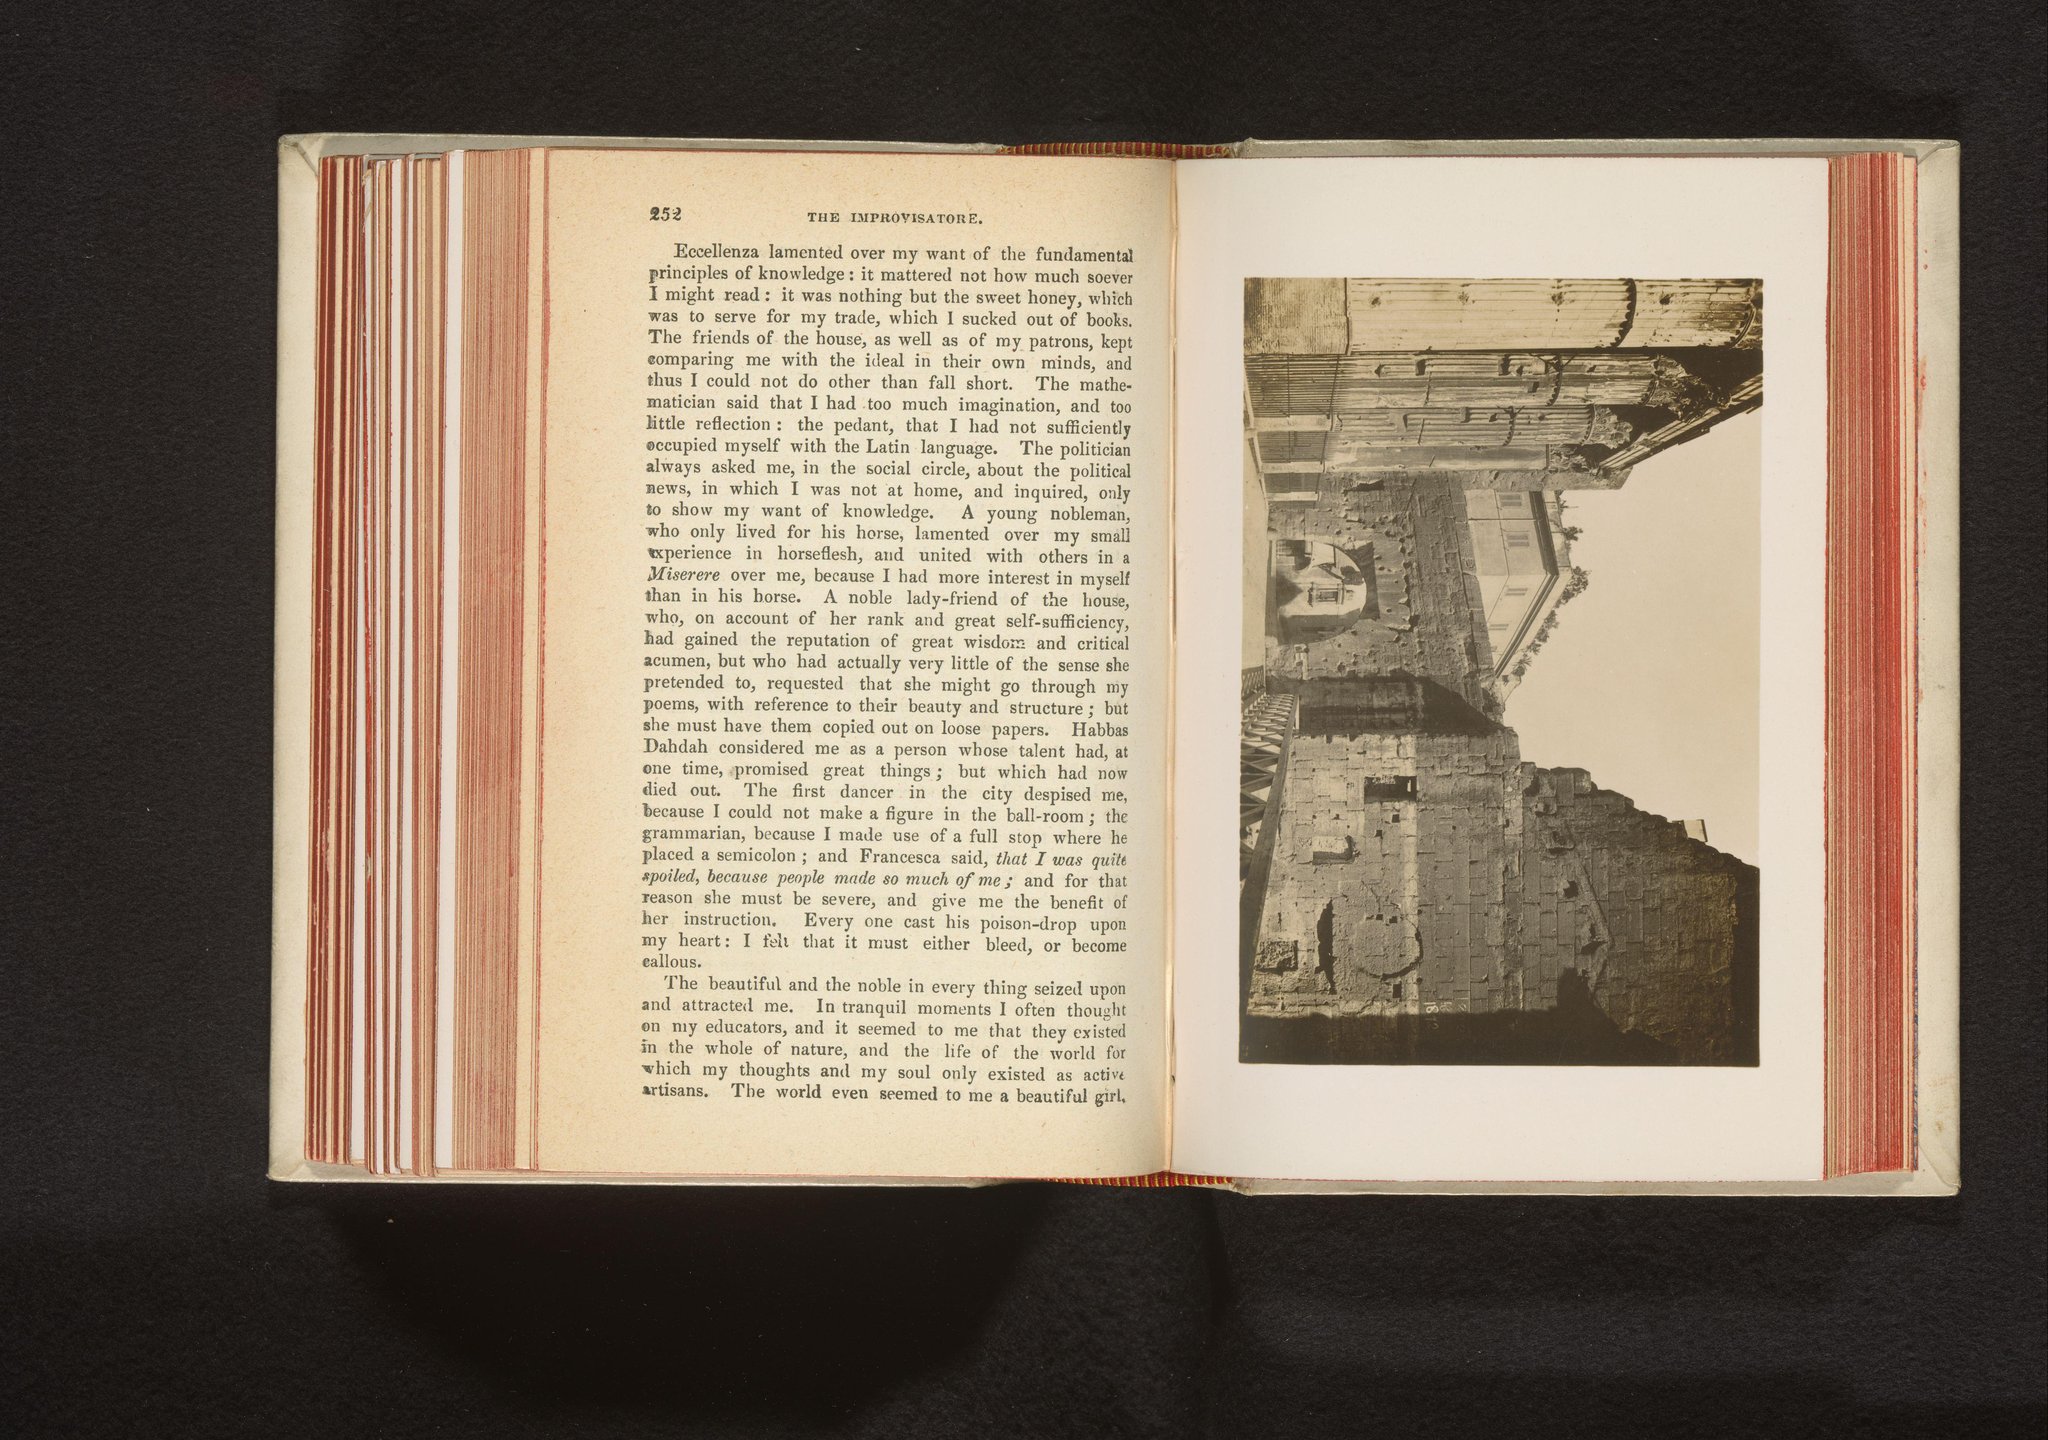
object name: page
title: Ruïnes te Rome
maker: Anonymous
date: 1870-1880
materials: photographic support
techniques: gelatin silver print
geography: rome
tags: ruin of a building ~ architecture